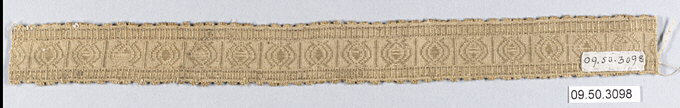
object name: gimp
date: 1701-1900